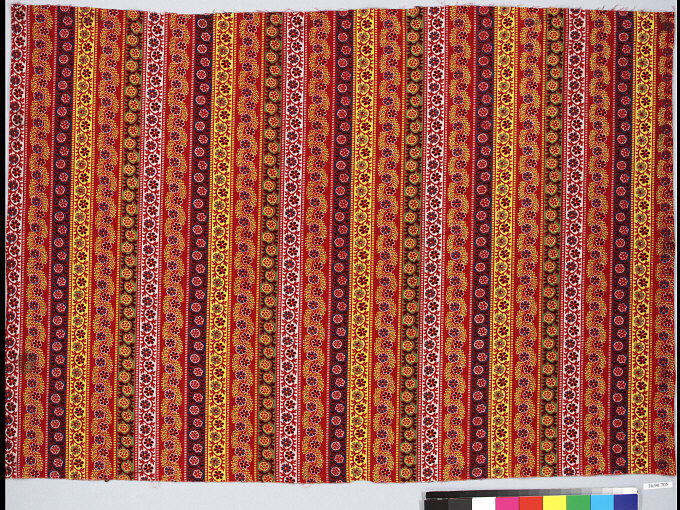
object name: piece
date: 1867-1900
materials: cotton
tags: flowers